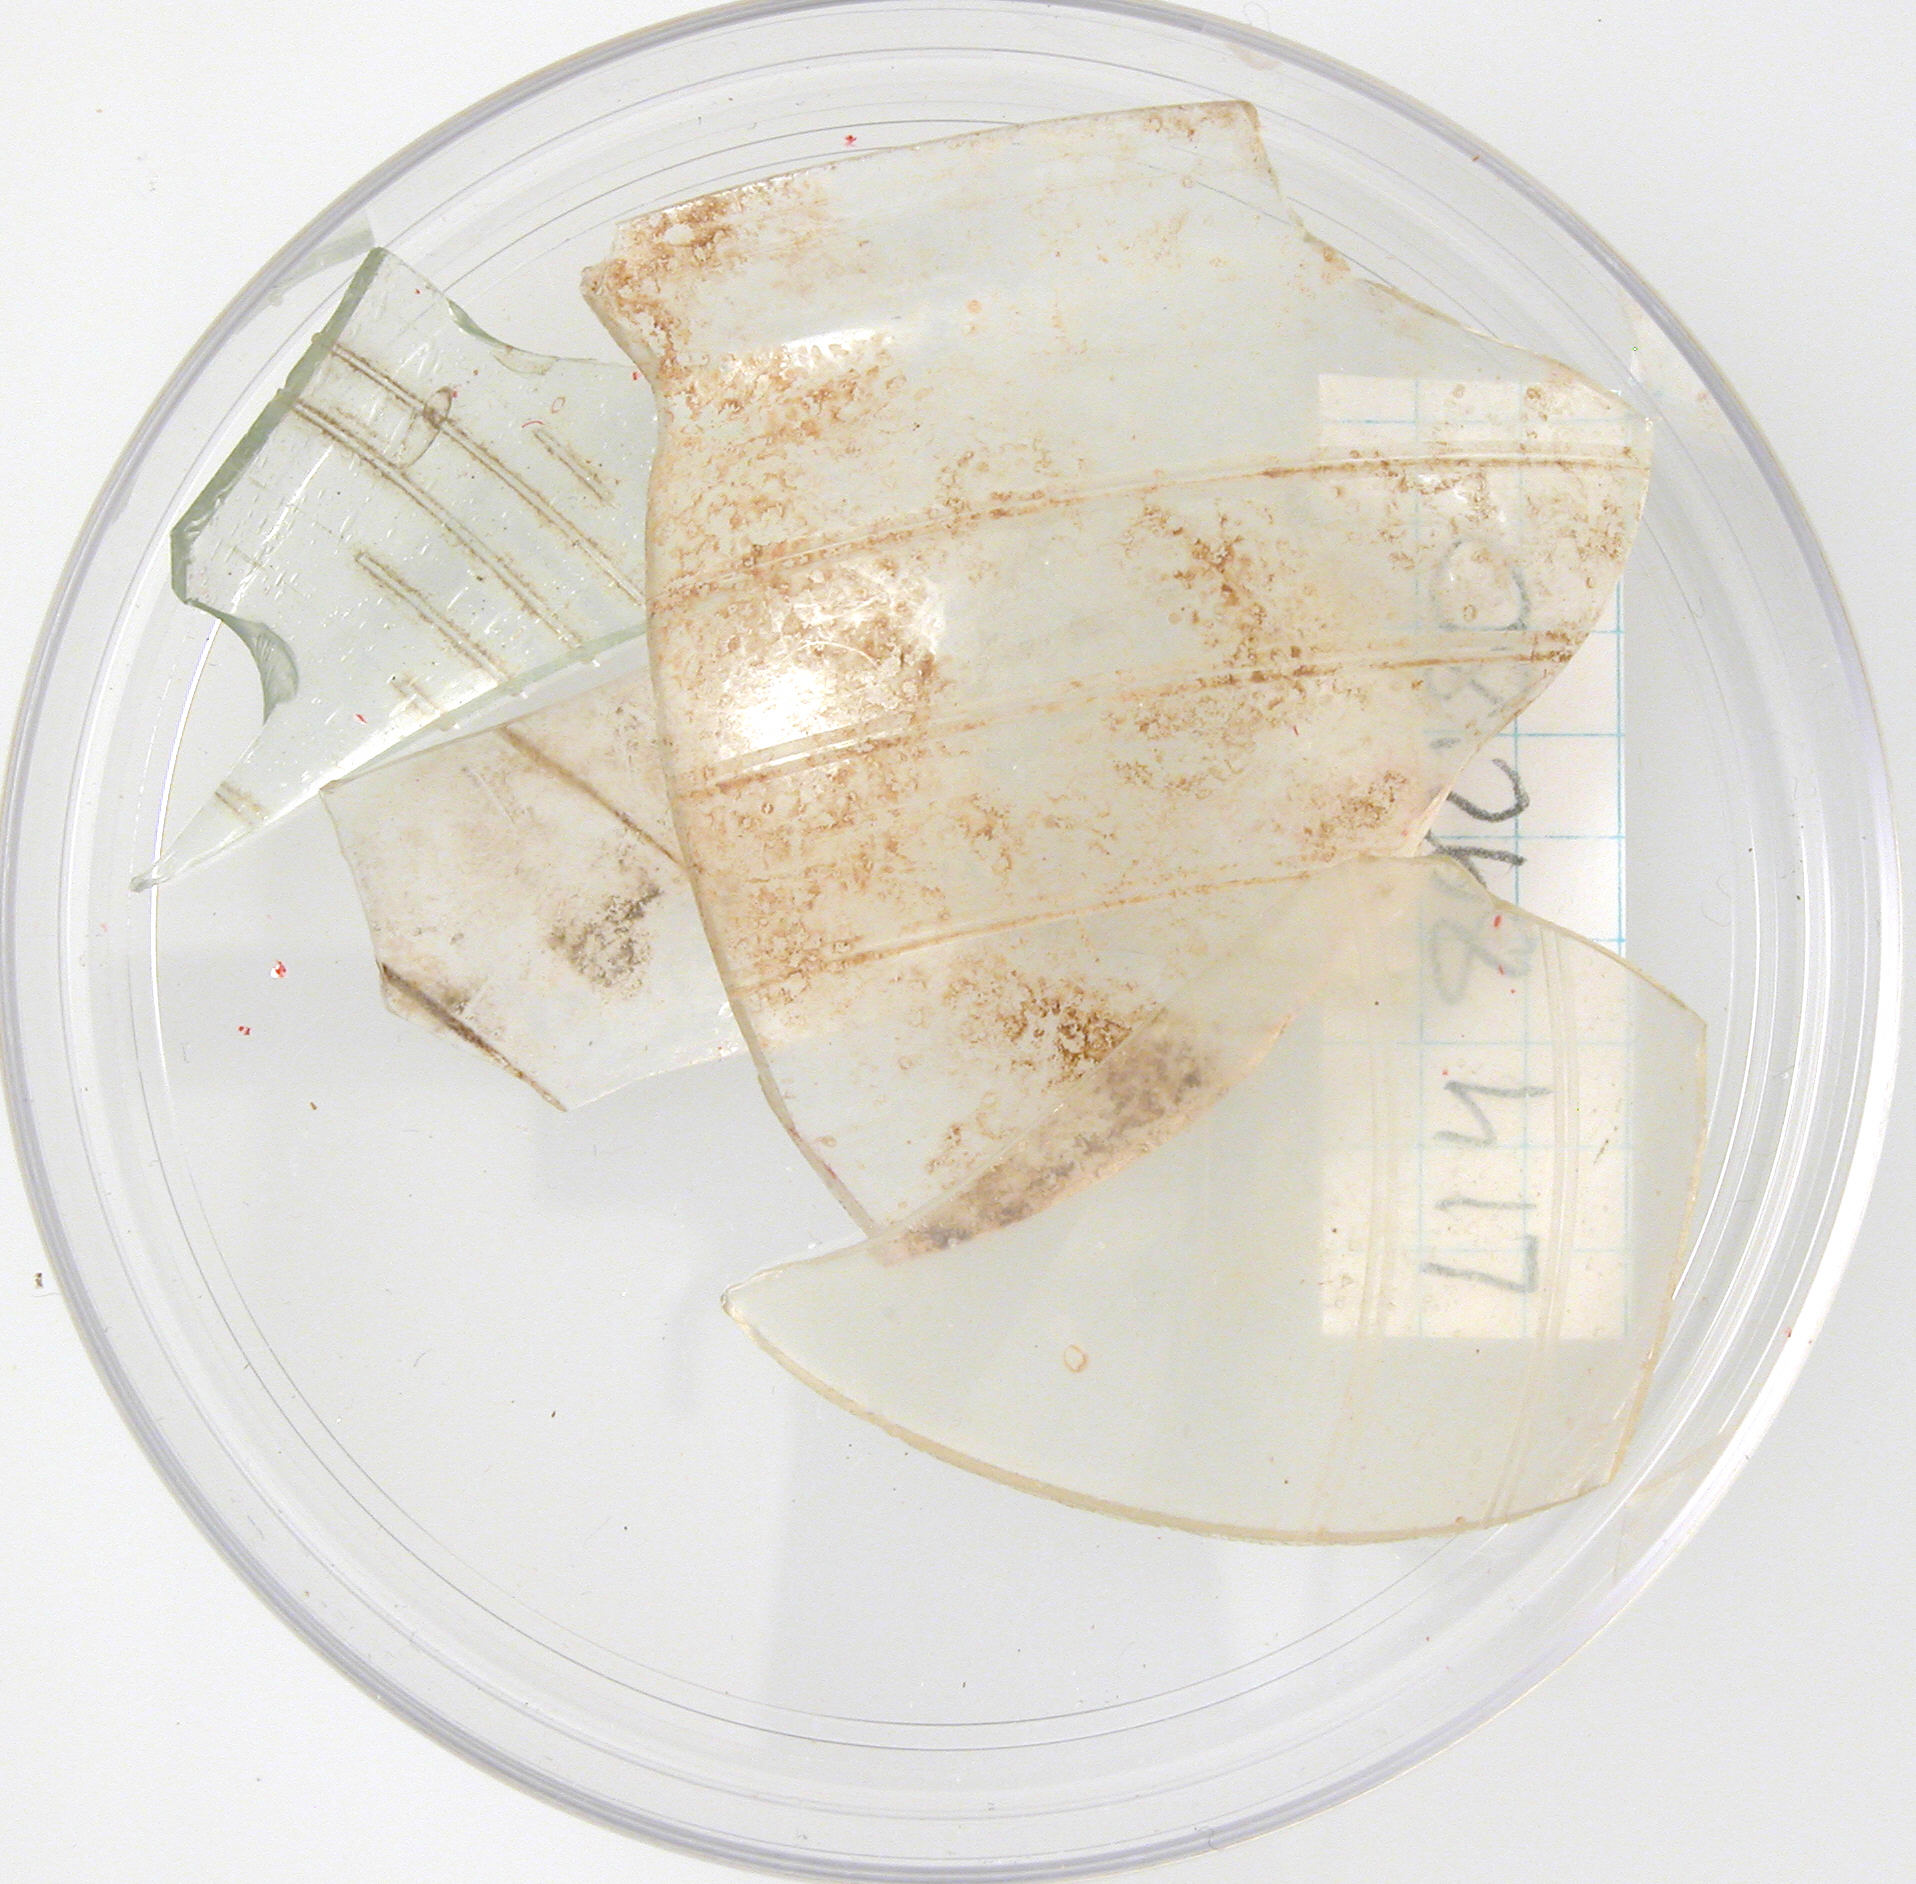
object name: fragment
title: Glass Fragments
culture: coptic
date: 301-433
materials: glass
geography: egypt